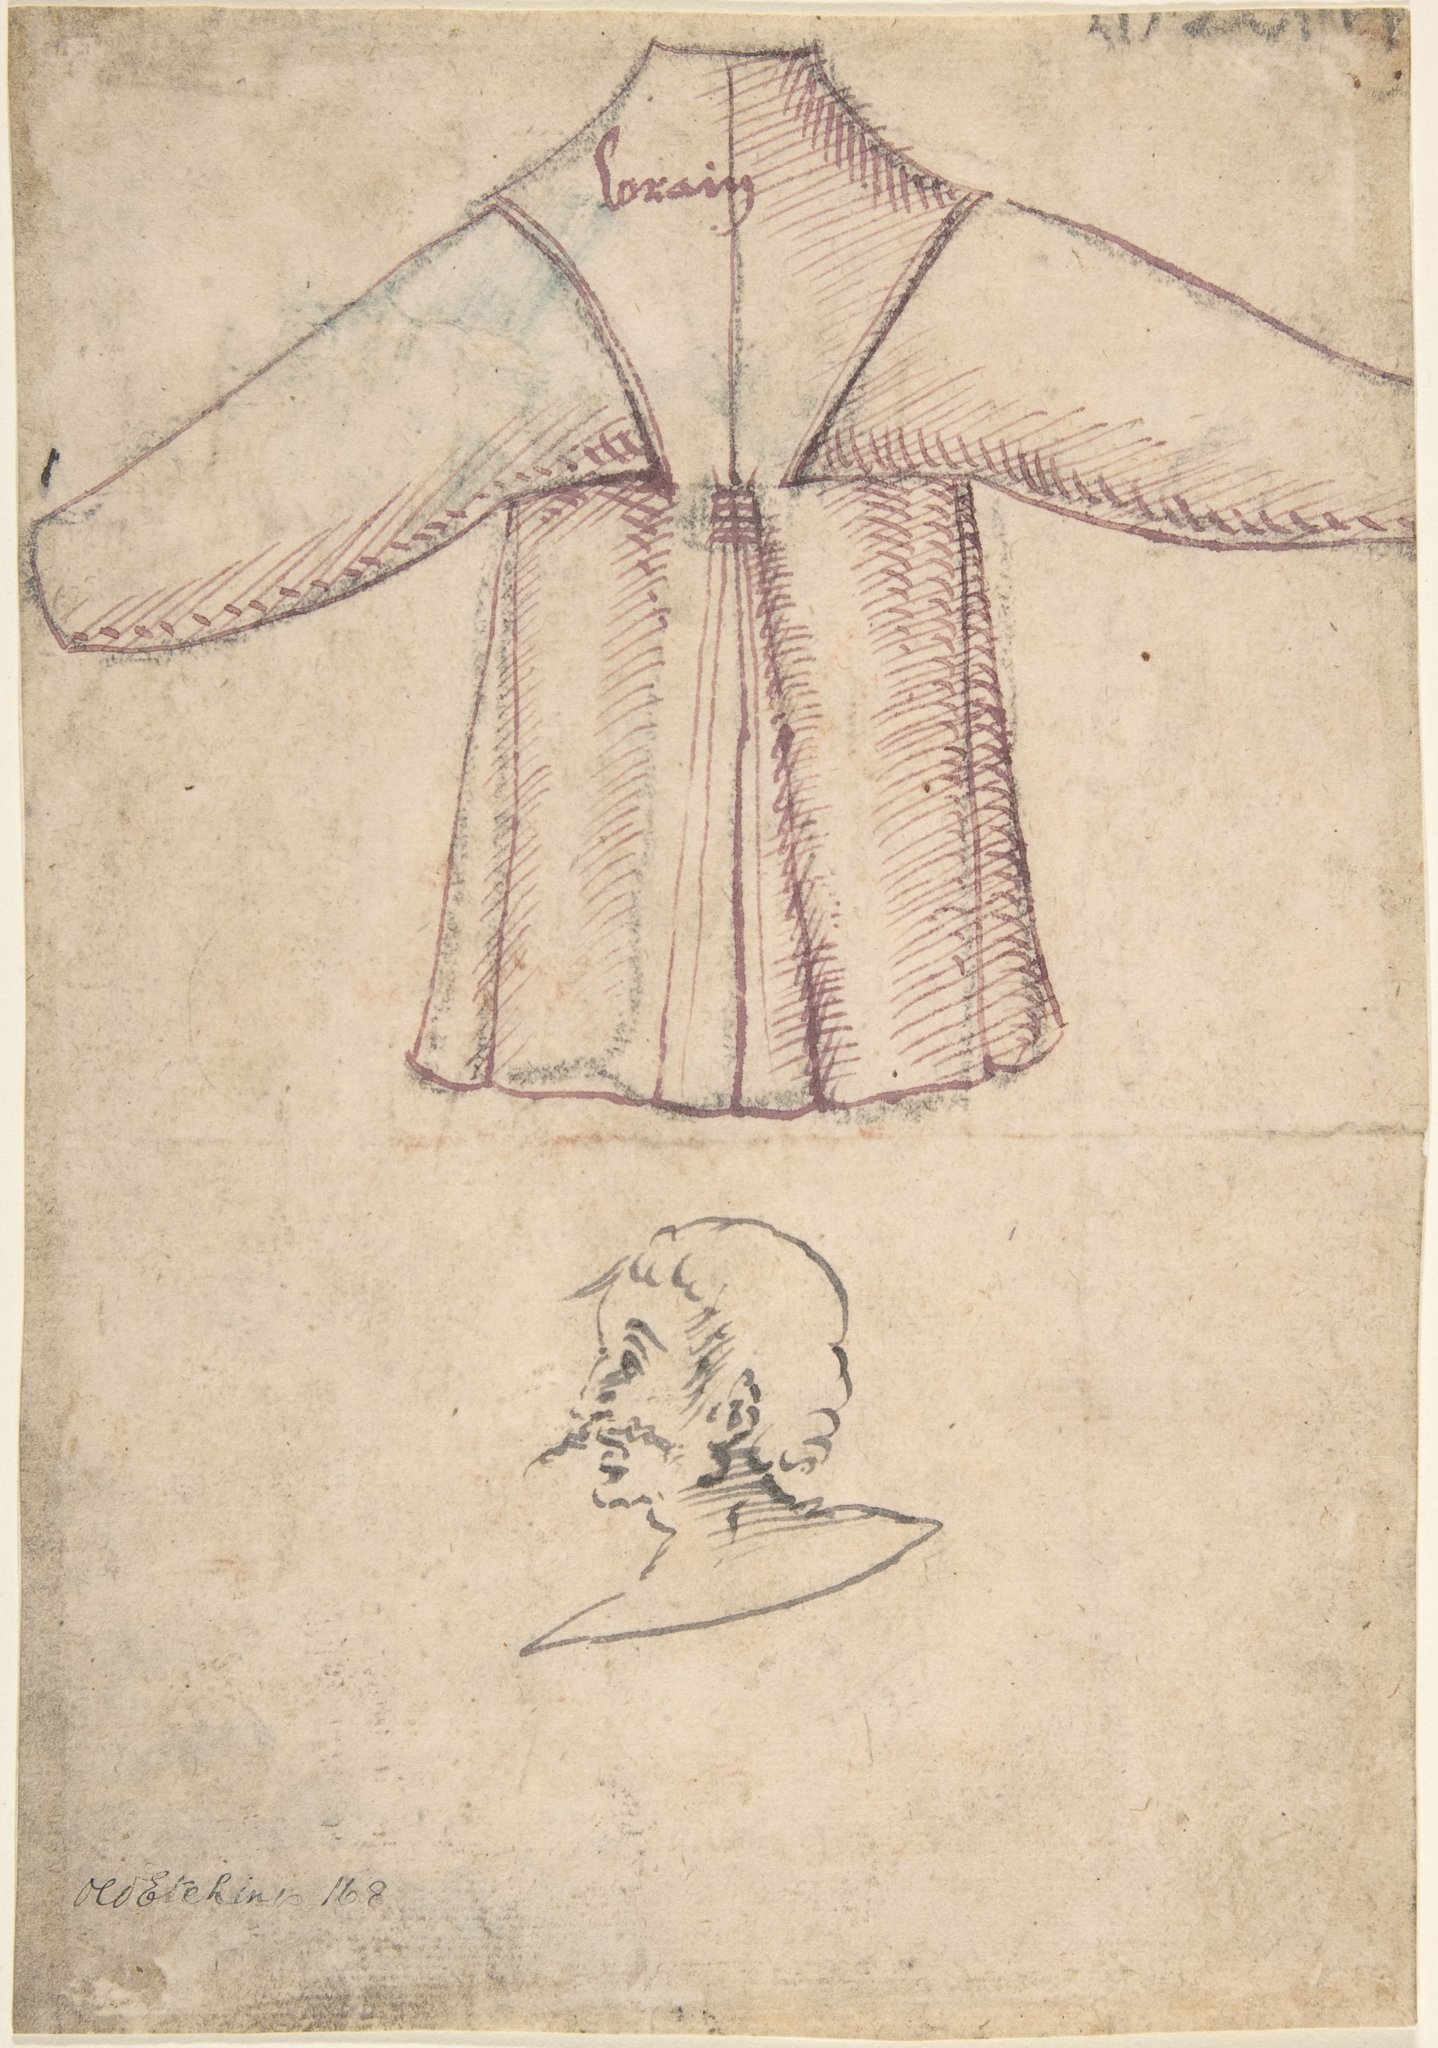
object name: drawing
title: A costume and a sketch of a man in profile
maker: anonymous, german, 16th century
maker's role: artist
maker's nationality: german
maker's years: 1500-1600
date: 1500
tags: costumes,men